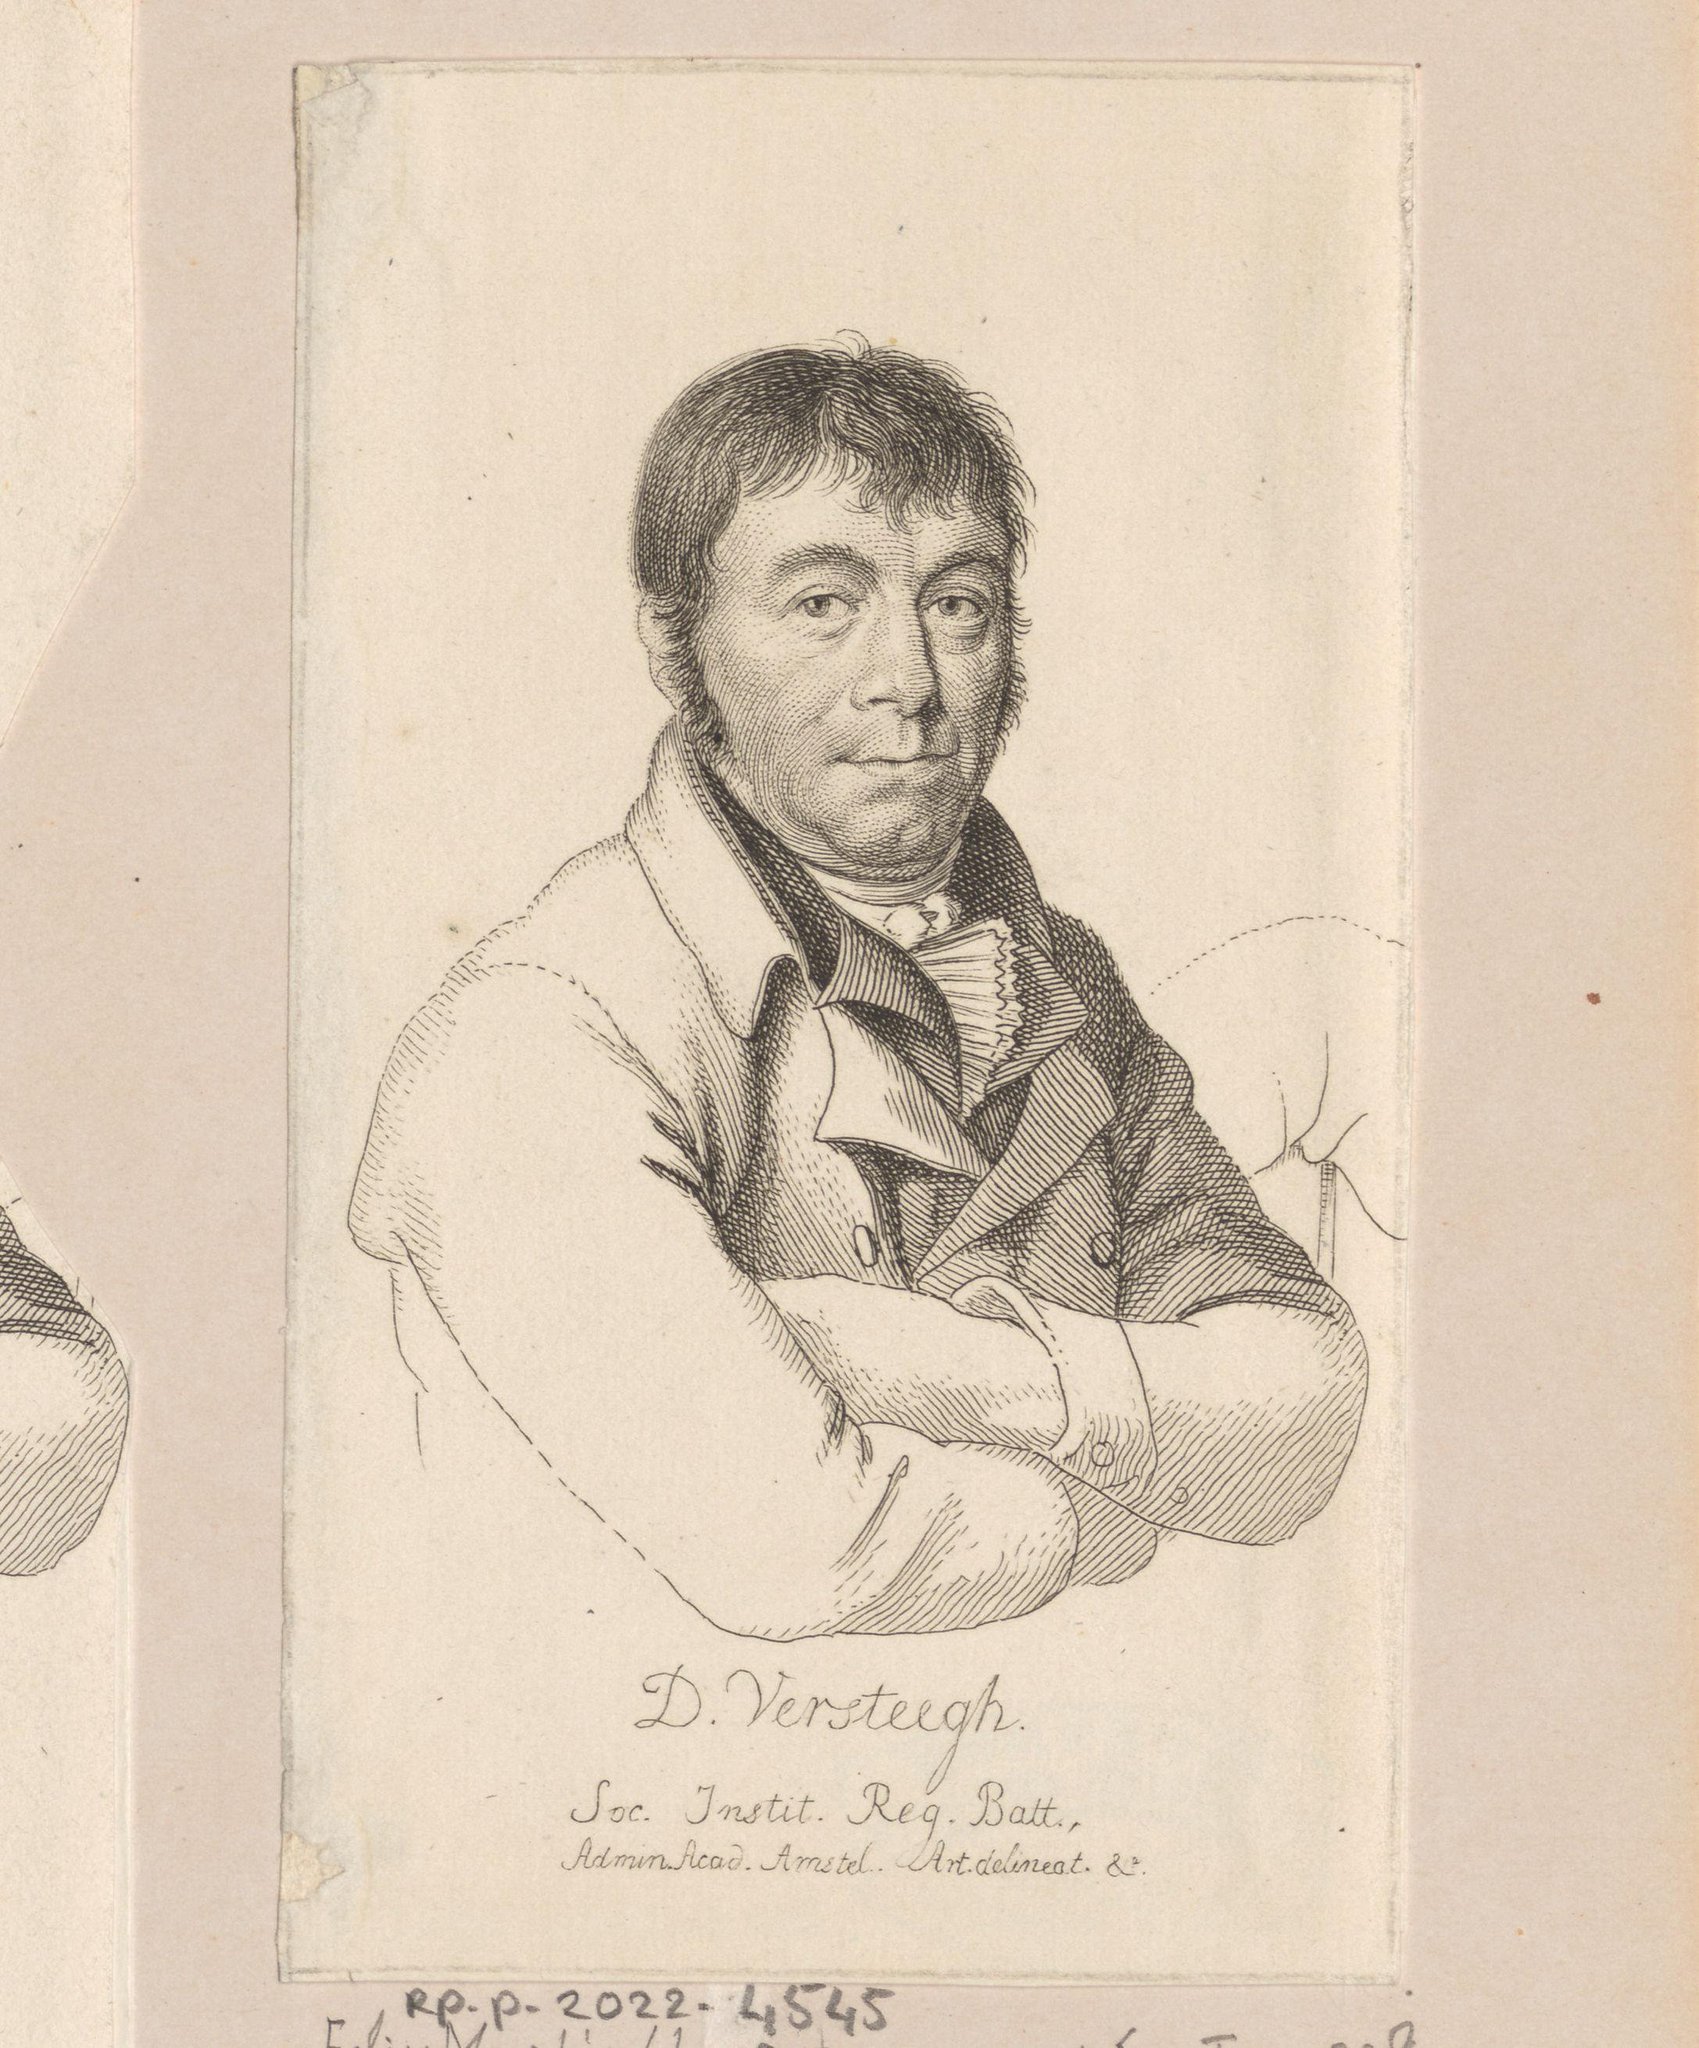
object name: print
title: Studiebeelden en fragmenten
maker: jacob ernst marcus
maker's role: draughtsman, print maker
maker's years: 1774-1826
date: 1812-1814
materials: paper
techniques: etching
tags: dirk versteegh, historical persons, portrait, self-portrait of artist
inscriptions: collector's mark: Lugt 924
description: De prenten verschenen eerst maandelijks tussen november 1807 en juli 1816. Later gebundeld uitgegeven als: Studie-prentwerk/ Etudes gravées, ca. 1817. In 1834 volgde nog een heruitgave.